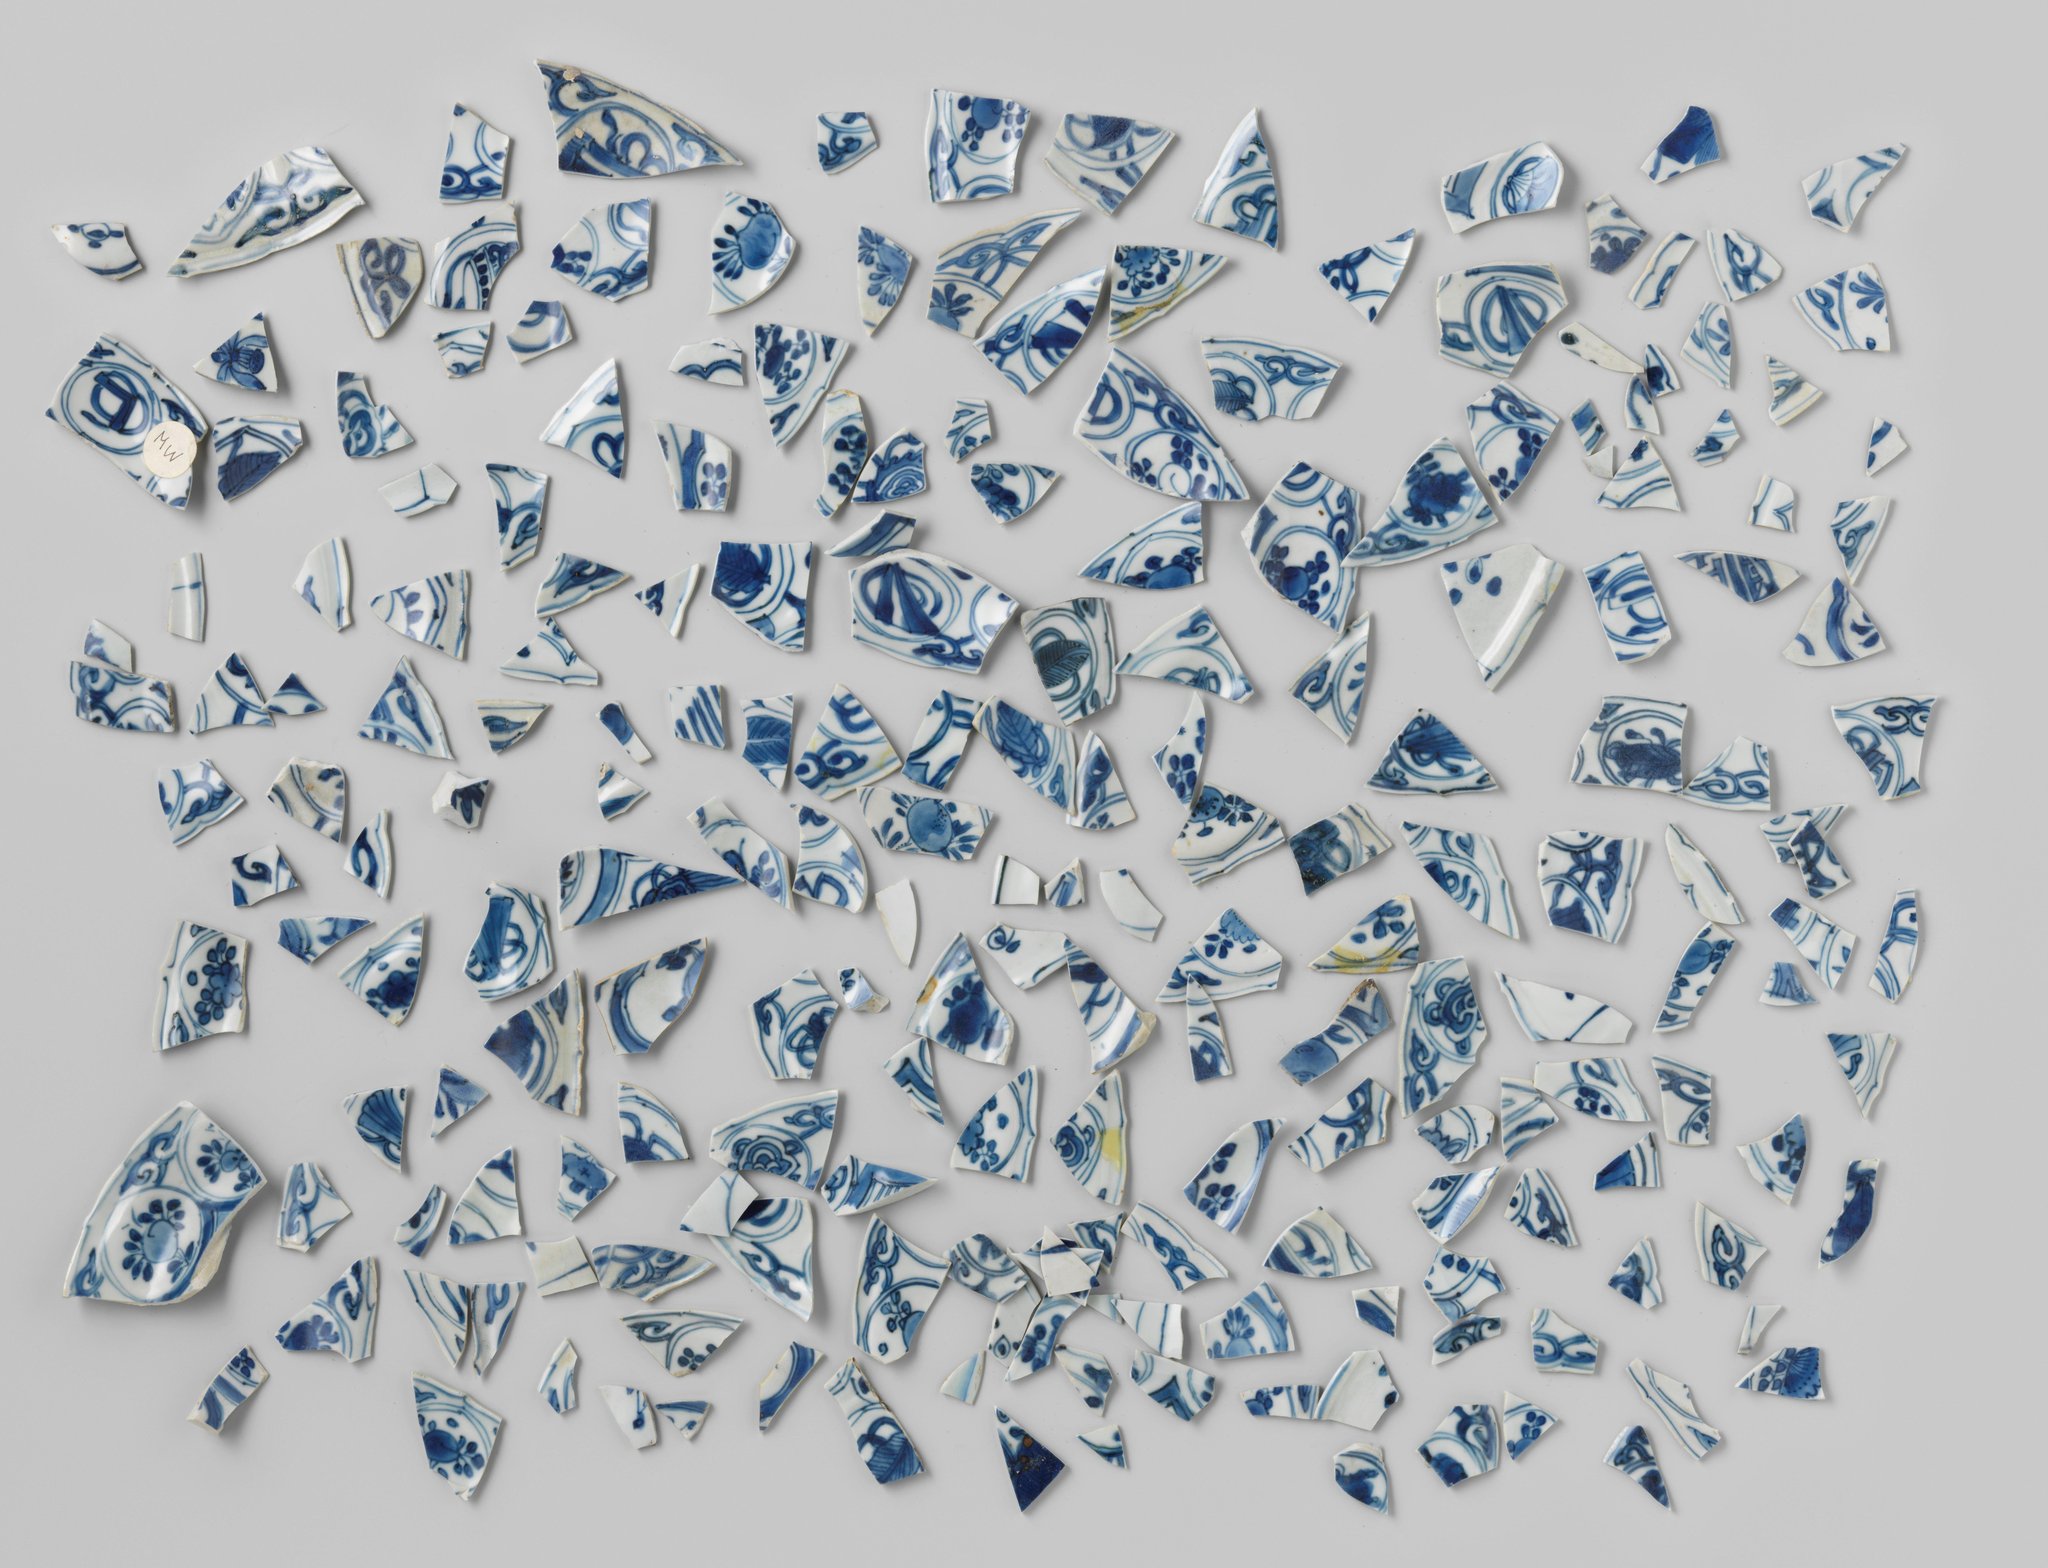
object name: plate dish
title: Scherven van borden uit V.O.C.-schip de 'Witte Leeuw'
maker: Anonymous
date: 1613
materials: bone china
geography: jingdezhen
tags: verenigde oostindische compagnie, sint-helena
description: Scherven van borden uit V.O.C.-schip de 'Witte Leeuw'.